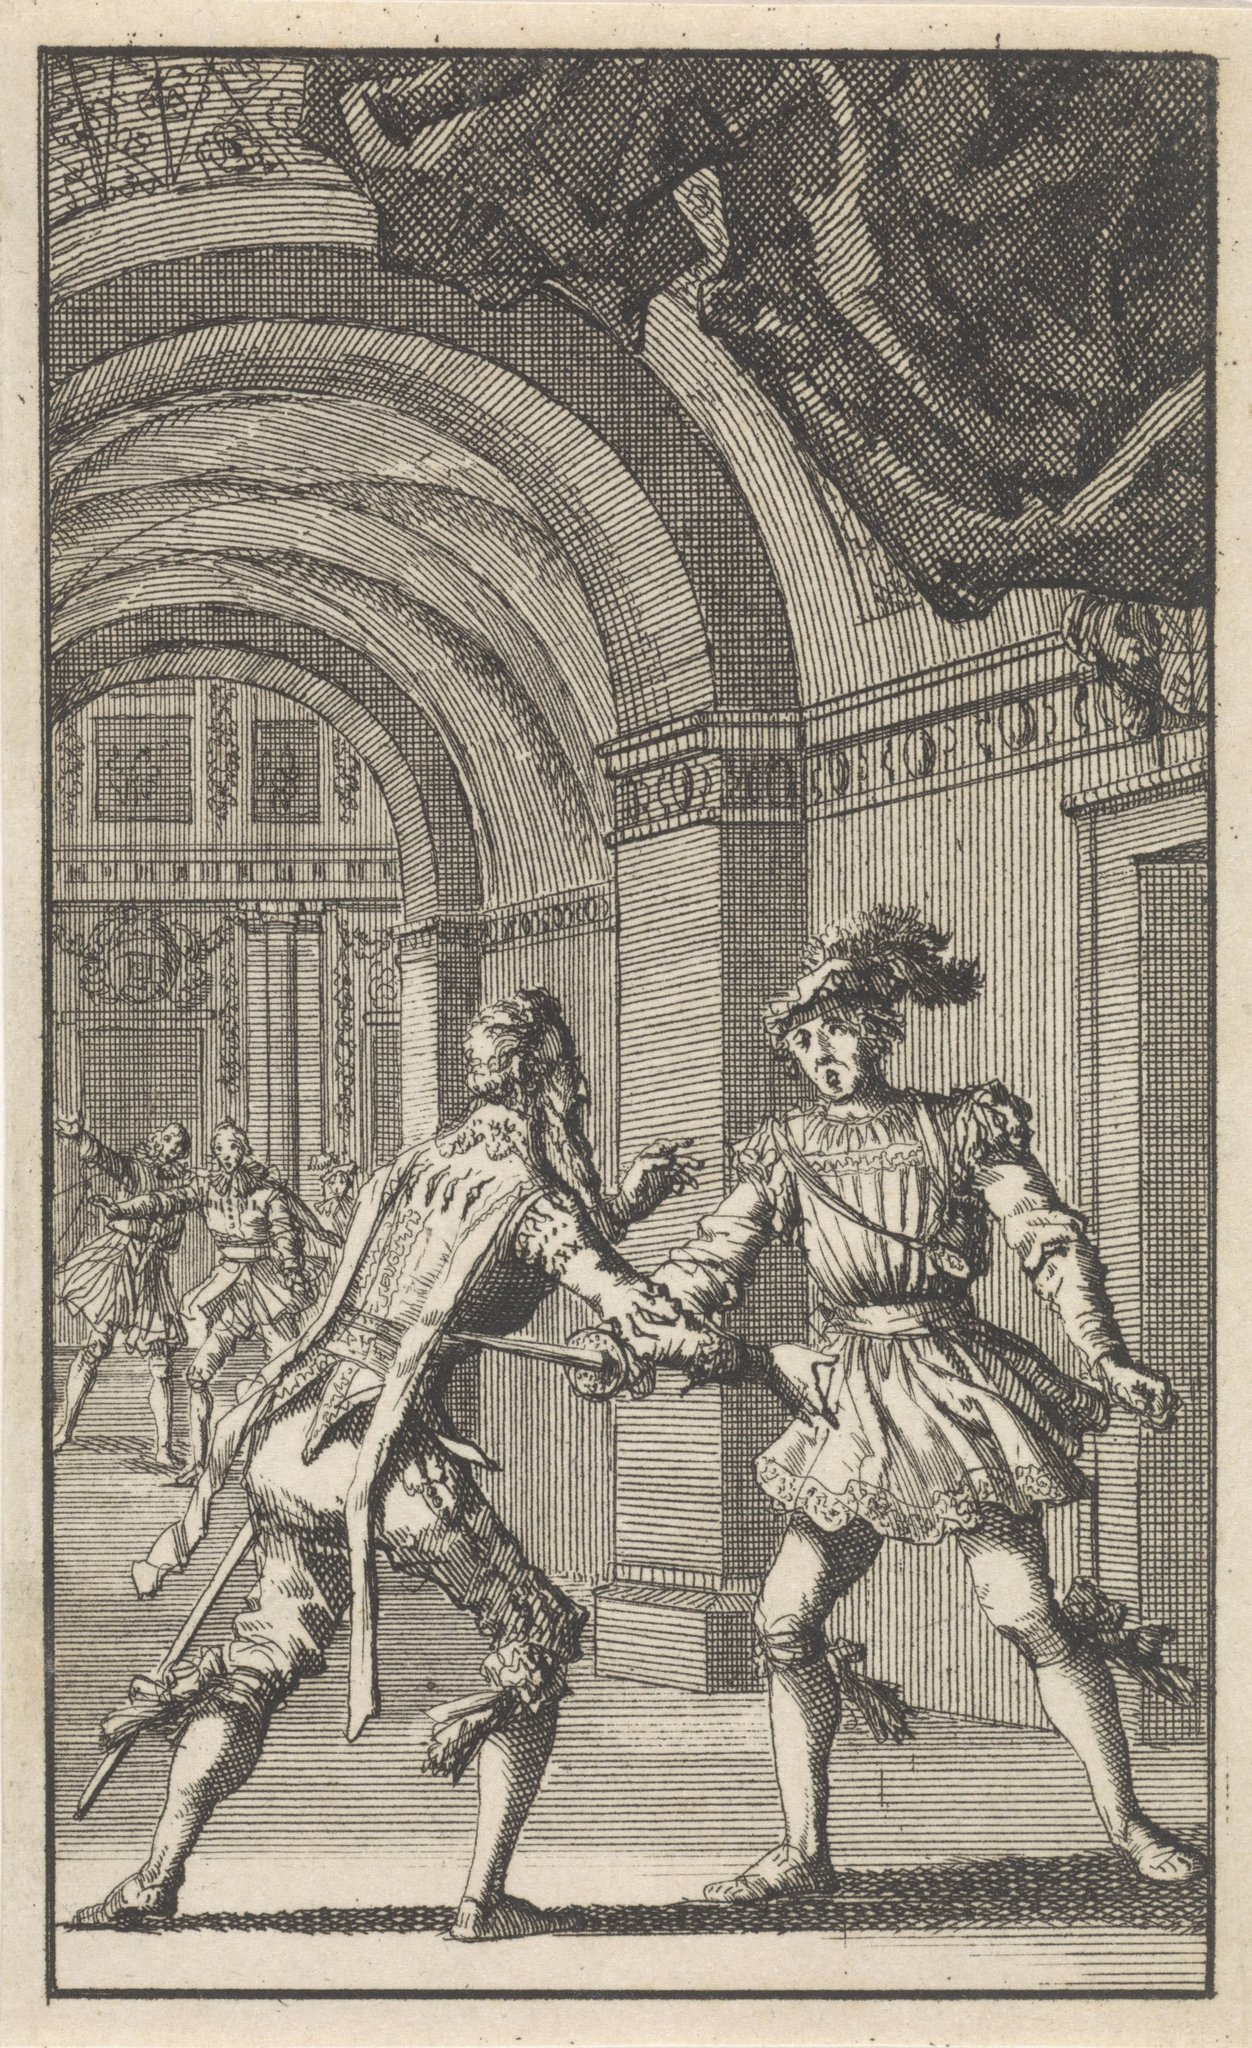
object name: history print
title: Don Carlos probeert de hertog van Alva te vermoorden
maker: jan luyken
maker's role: draughtsman, print maker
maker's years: 1649-1712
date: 1699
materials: paper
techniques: etching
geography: amsterdam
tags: fernando álvarez de toledo (3rd duke of alba), violent death by dagger, knife - ee - death not certain; wounded person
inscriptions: collector's mark: Lugt 2228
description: Latere boekillustratie voor Leti, Gregorio. Het Leven van Filips de II, Koning van Spanien. Vertaald door N.J. Wieringa. Den Haag: Engelbreght Boucquet, 1699.